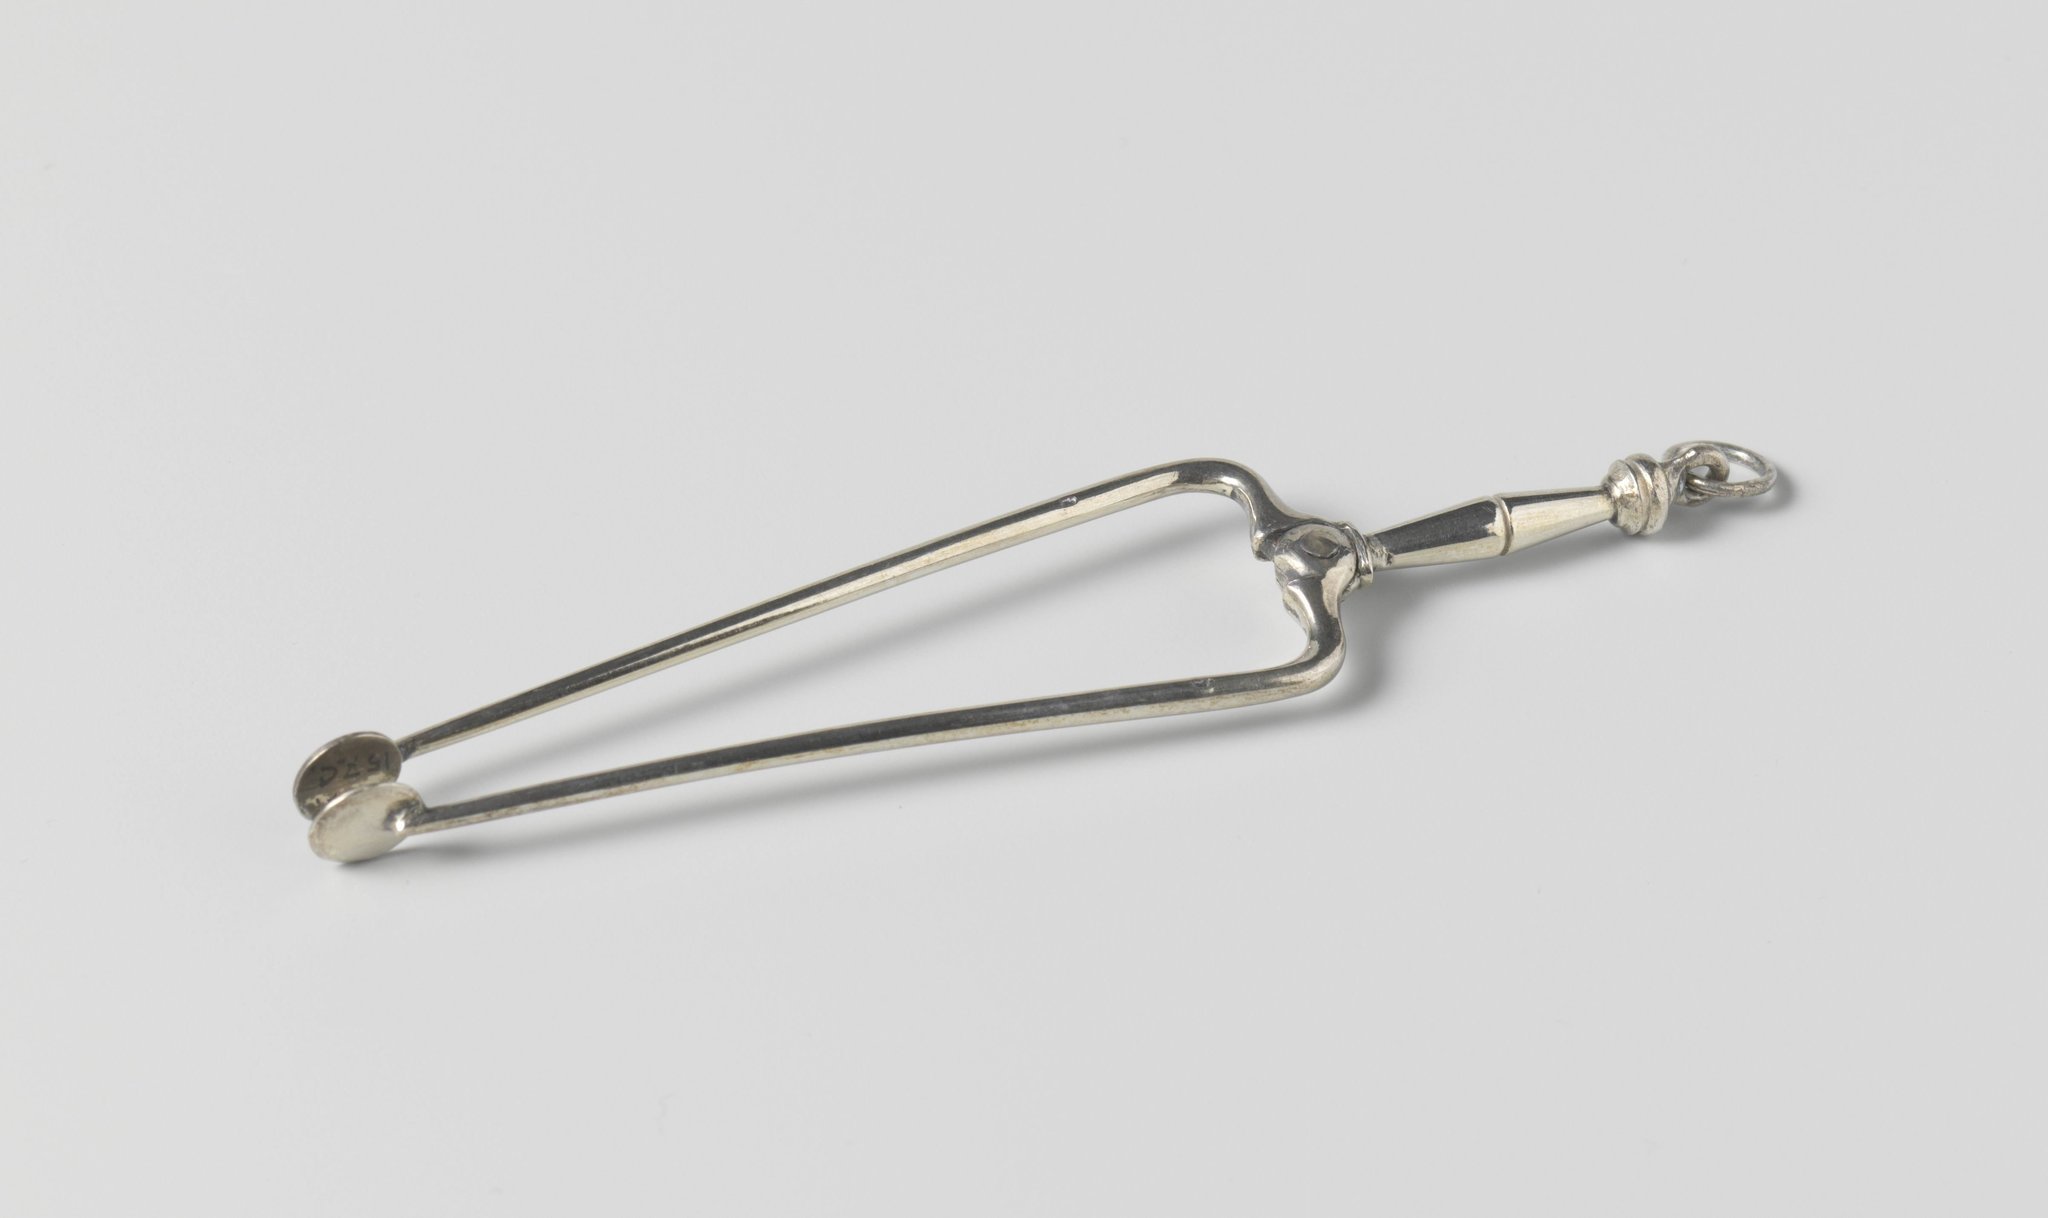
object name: miniature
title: Haardtang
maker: hendrik duller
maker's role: silversmith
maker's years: 1749-1820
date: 1788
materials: silver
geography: amsterdam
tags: fire-tongs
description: Vuurtang met gladde benen en een ring aan het uiteinde van het handvat. De vuurtang is gemerkt: stk.= Amsterdam, jrl.= D (1788) en mt.= H. Duller. De vuurtang wordt bewaard als onderdeel van een haardstel (BK-NM-11177-157).